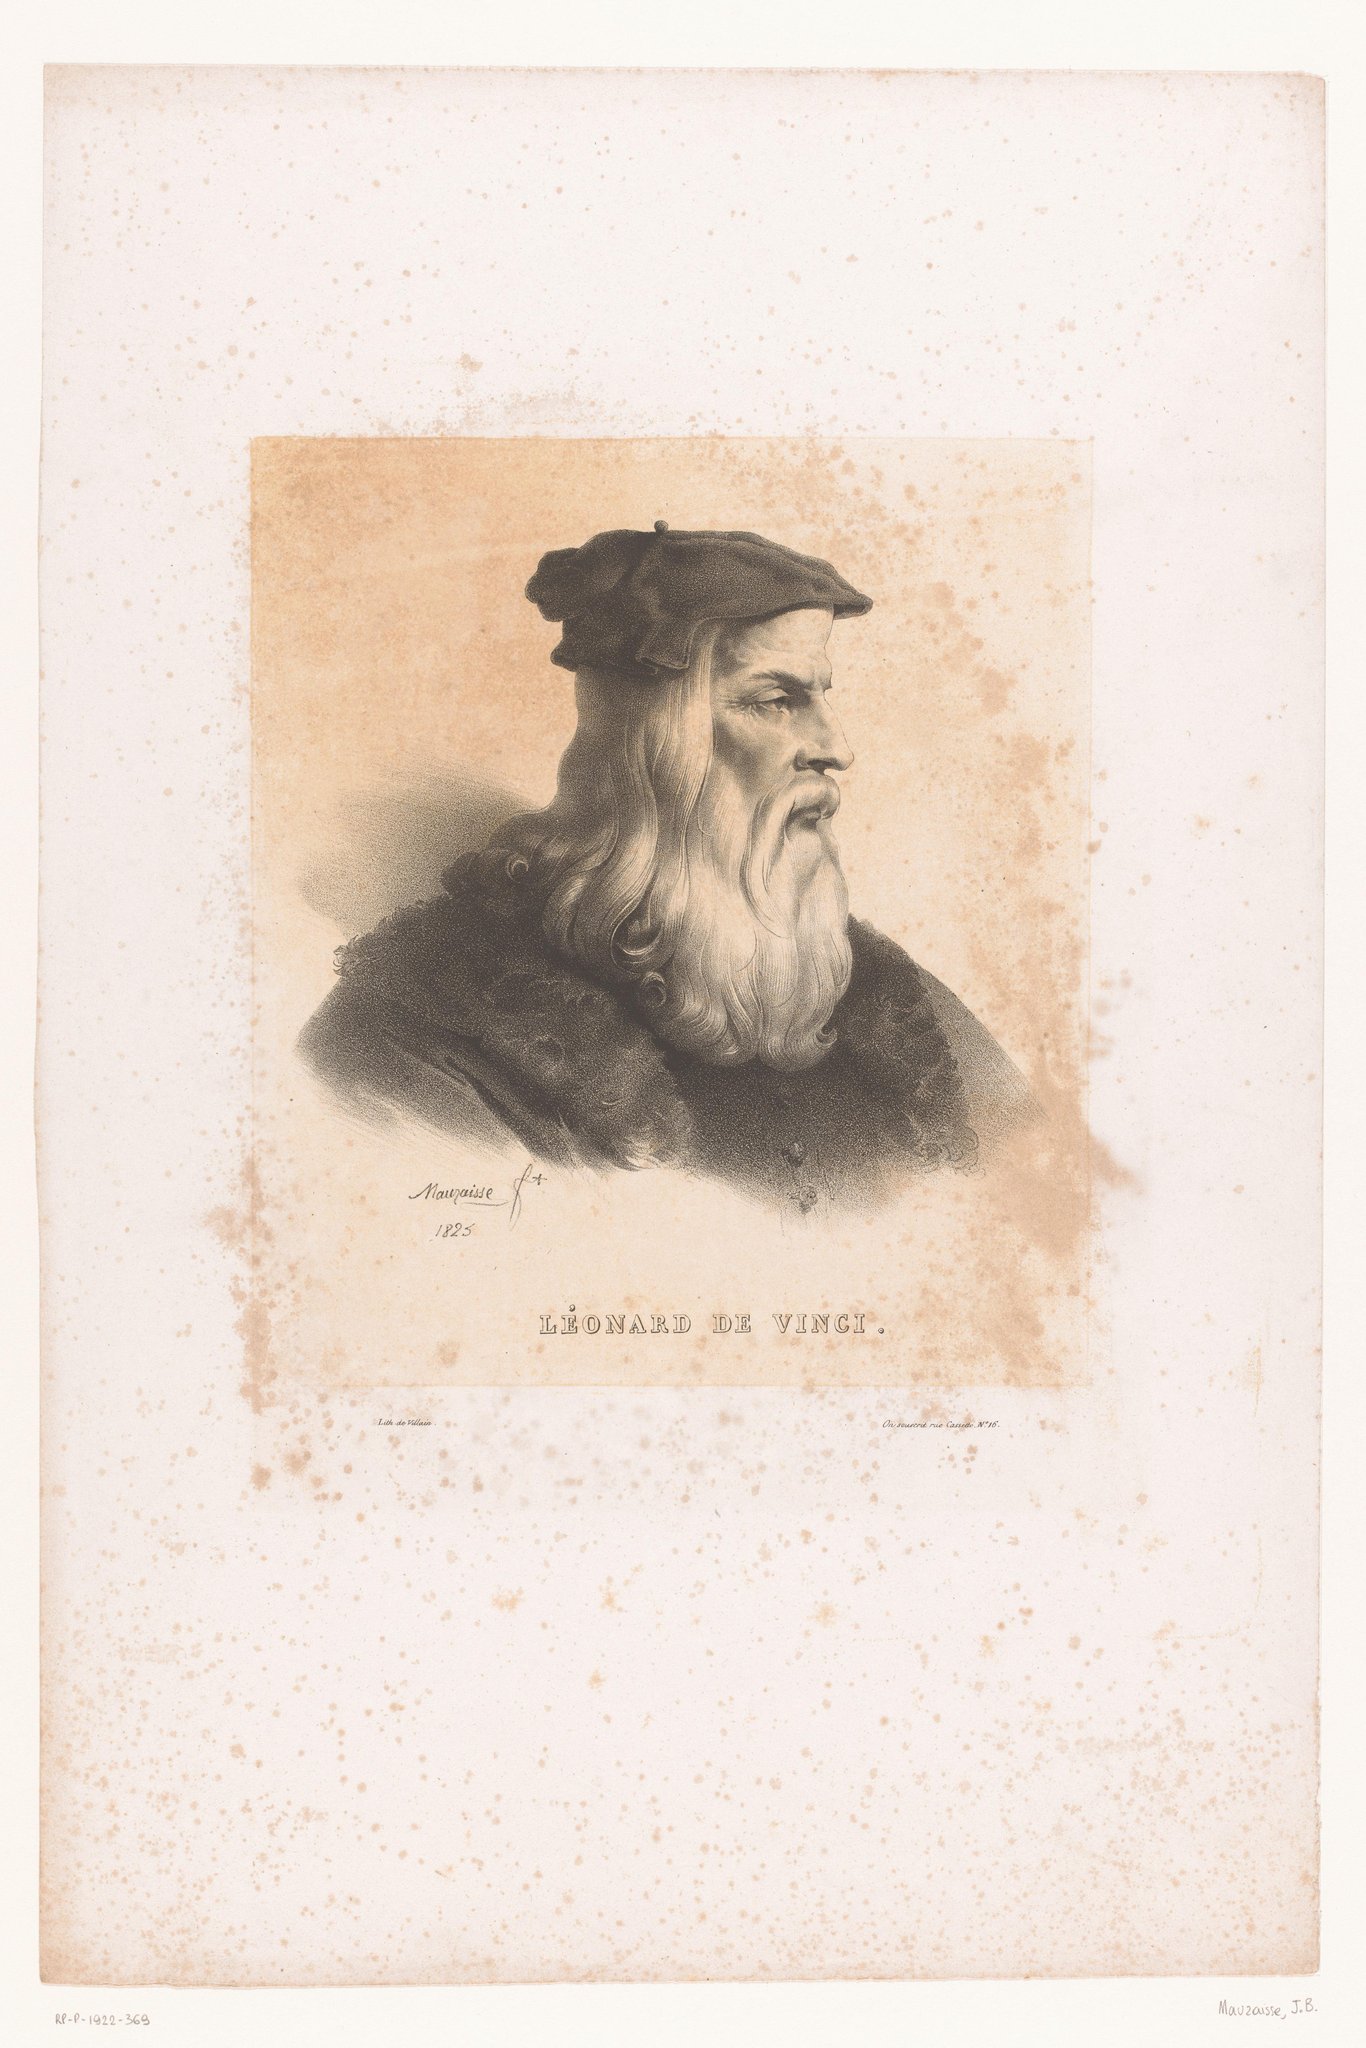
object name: print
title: Léonard de Vinci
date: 1825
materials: paper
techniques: tone lithography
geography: paris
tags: artist, leonardo da vinci, head-gear, portrait, self-portrait of sculptor, historical persons, portrait, self-portrait of architect, portrait, self-portrait of painter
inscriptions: check stamp: ‘JC’, collector's mark: Lugt 2233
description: Prent waarschijnlijk ook gebruikt in: Chabert, Jean Claude. Galerie des peintres ou collection de portraits des peintres les plus célèbres de toutes les écoles. Accompagnée d'une notice sur chacun d'eux, et de copies de dessins originaux / Galerie des peintres ou collection de portraits des peintres les plus célèbres de toutes les écoles. Accompagnée de leur notice historique, de leurs dessins et d'un discours sur les arts. Parijs: Jean Claude Chabert, s.a. [1822-1834]. De samenstelling van tegenwoordig bekende en al dan niet gebonden exemplaren van deze uitgave verschillen. Dit omdat de prenten en bijhorende stukken tekst op inschrijving en waarschijnlijk ook los verkrijgbaar waren.